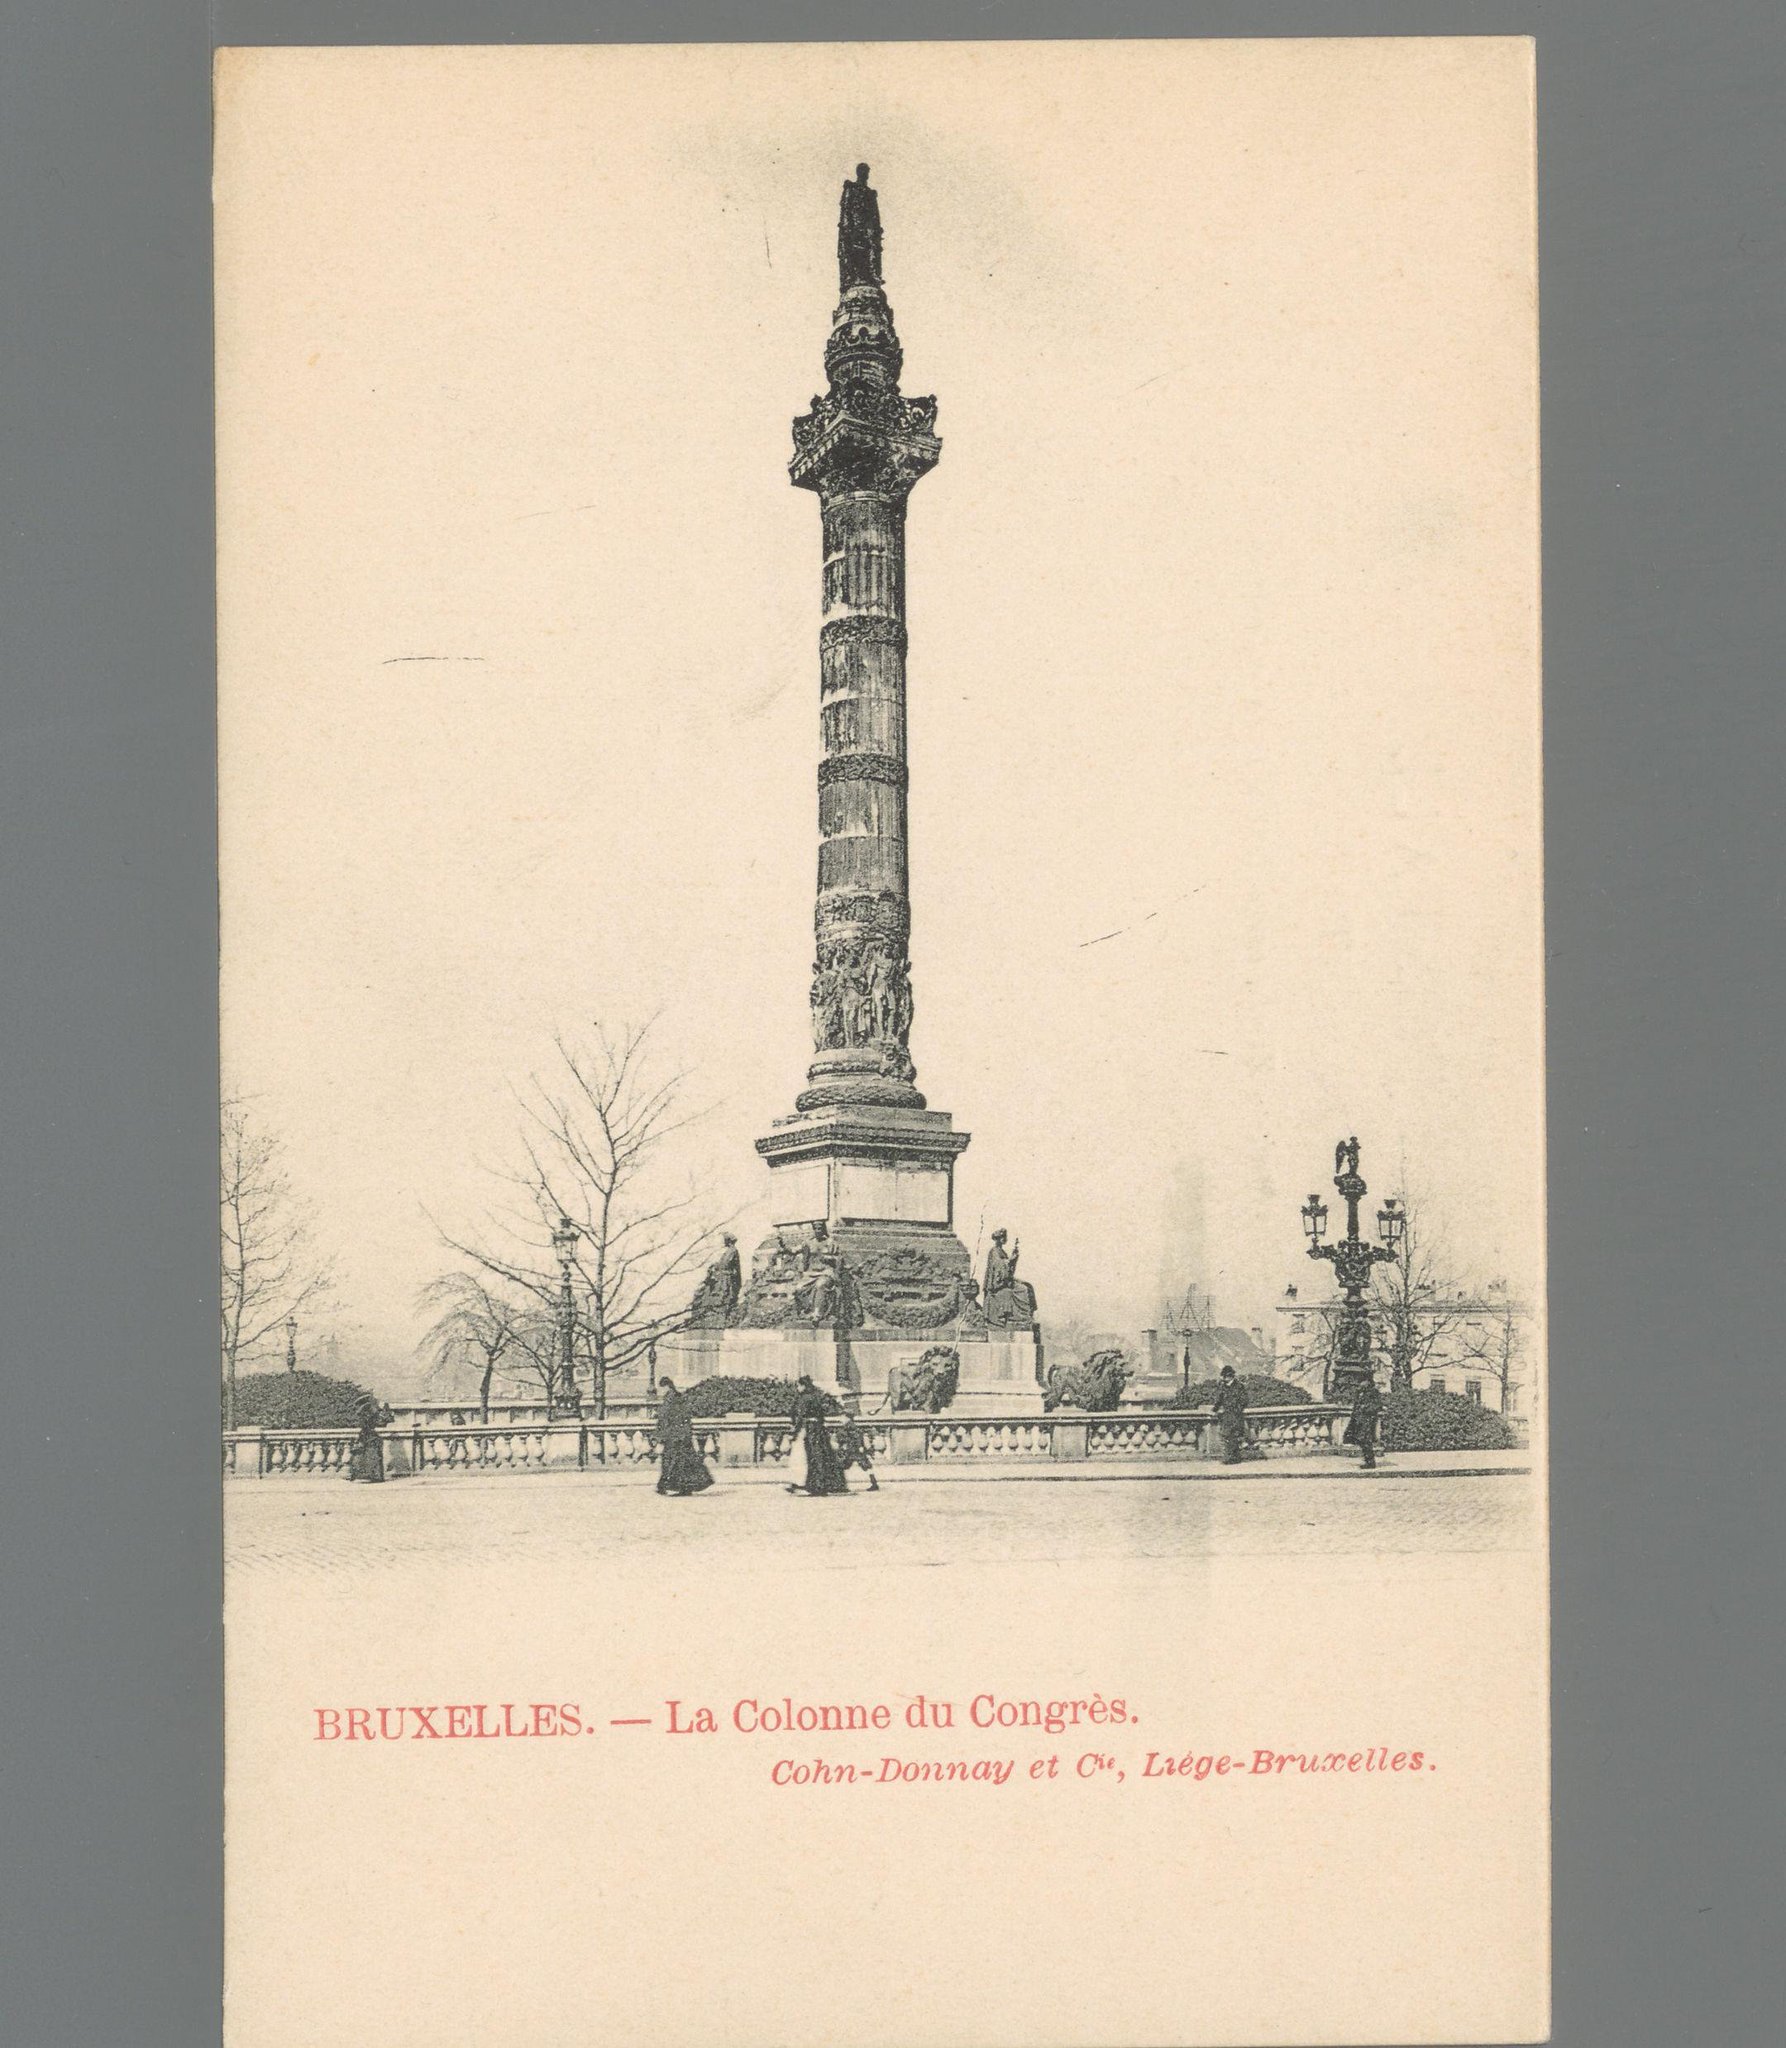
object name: photomechanical print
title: Bruxelles. La Colonne du Congrès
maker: Anonymous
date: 1903-1906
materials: cardboard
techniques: photograph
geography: brussels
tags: monument, statue, city-view, and landscape with man-made constructions (+ city(-scape) with figures, staffage)